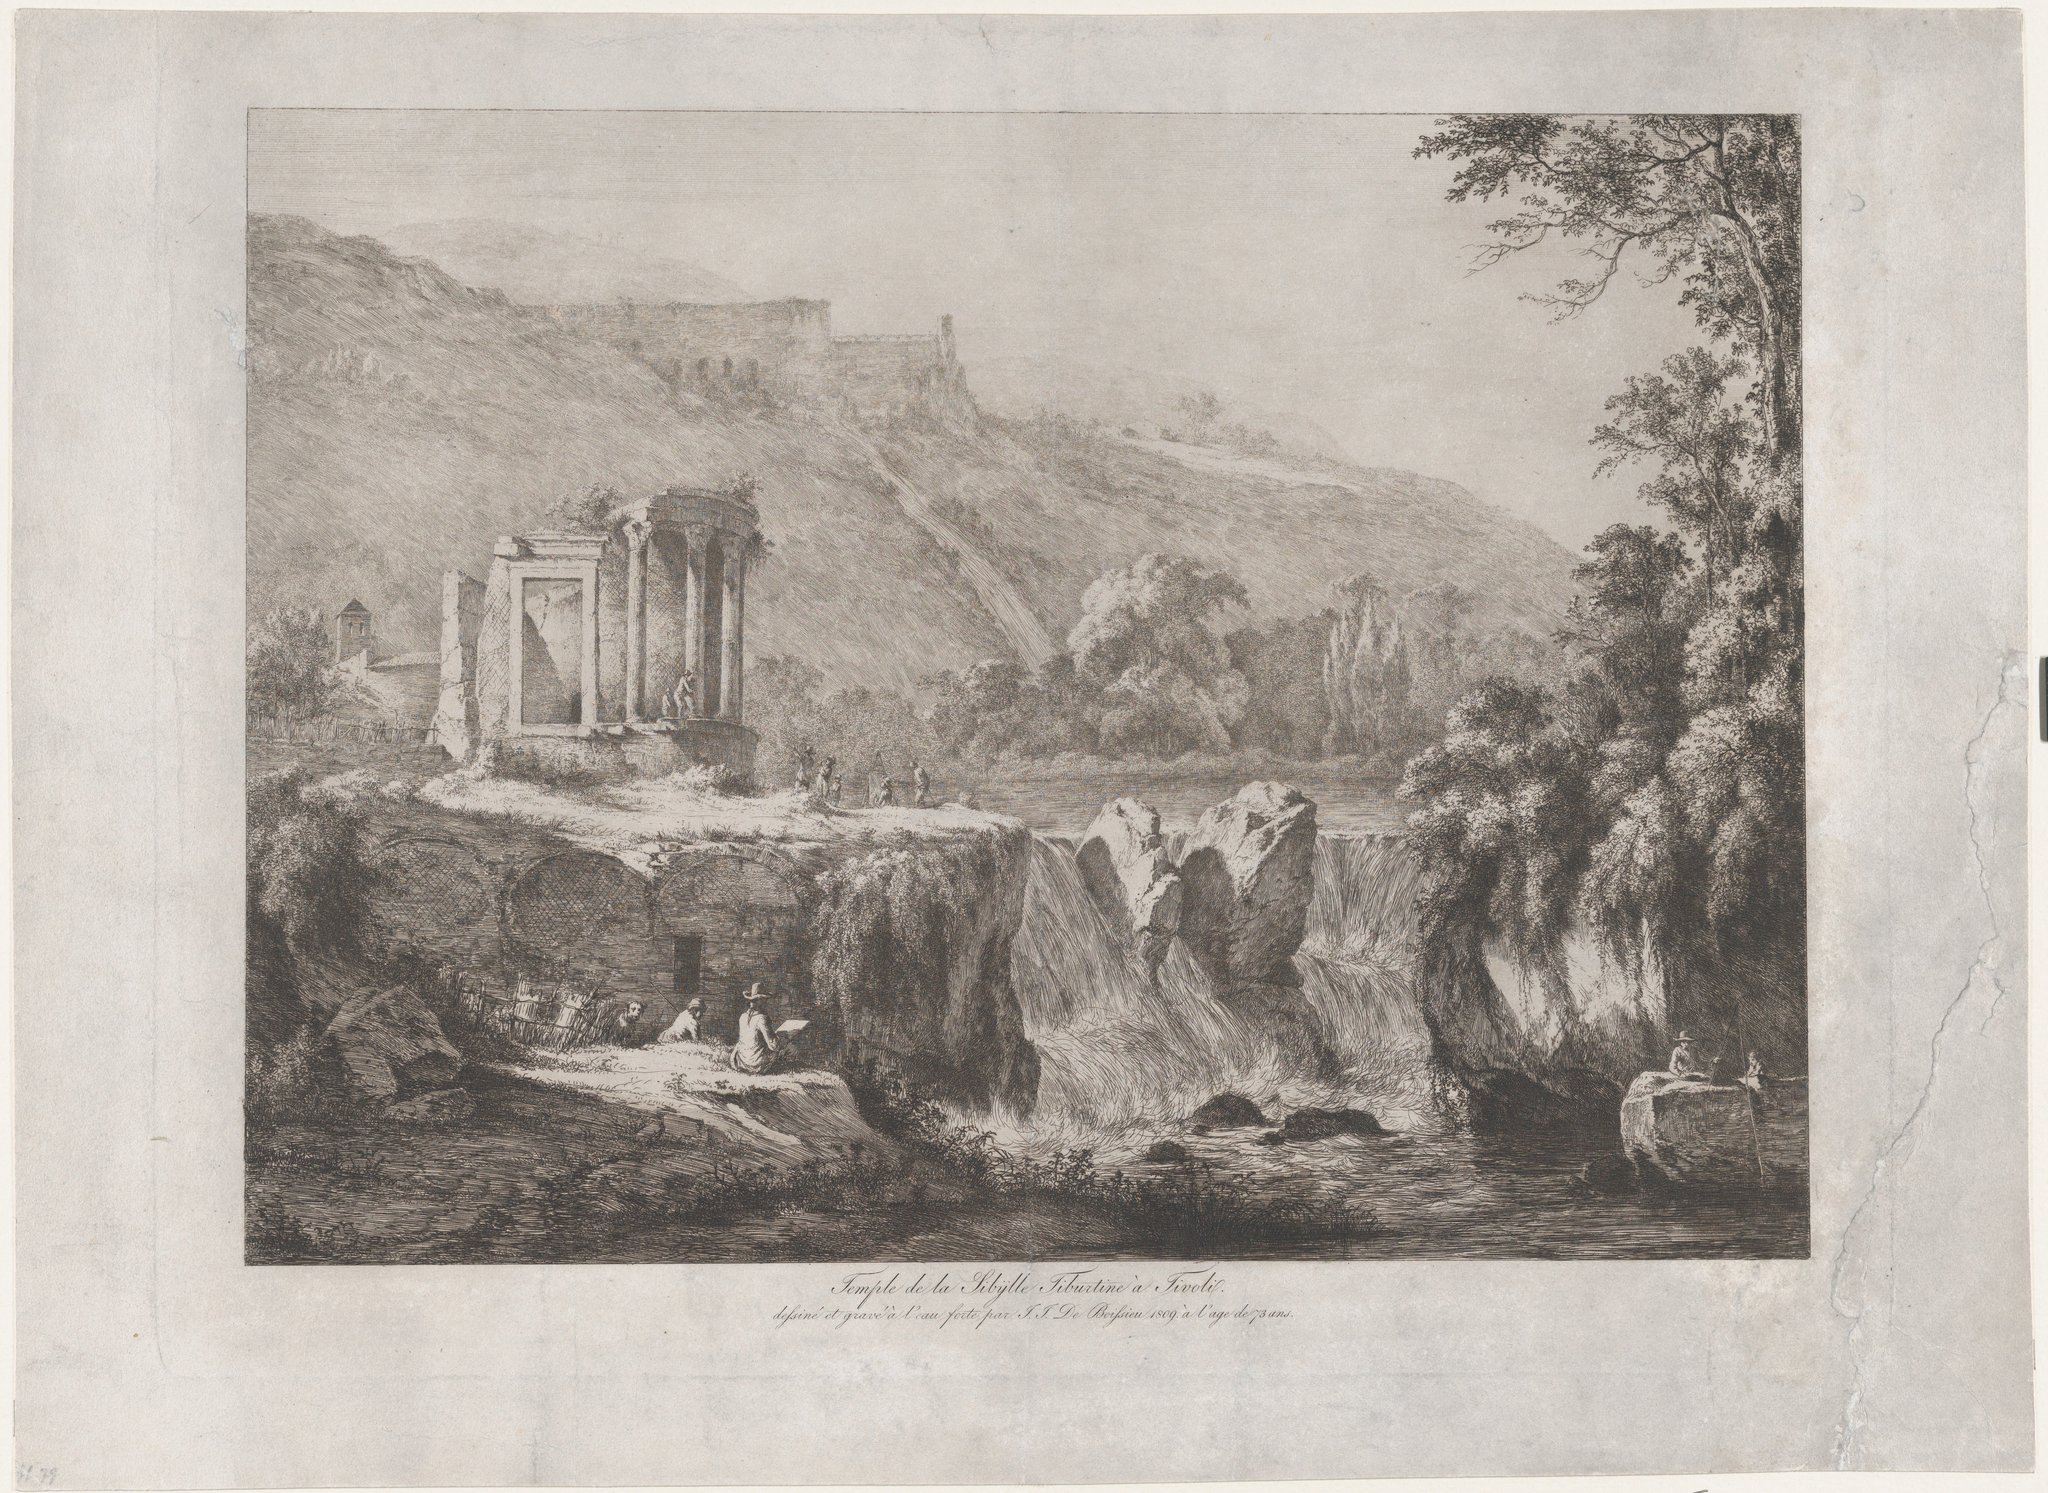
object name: print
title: View of the Temple of the Tiburtine Sibyl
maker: jean jacques de boissieu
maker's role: artist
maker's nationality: french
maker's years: 1736-1810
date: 1809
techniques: drypoint, etching, roulette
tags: temples,landscapes